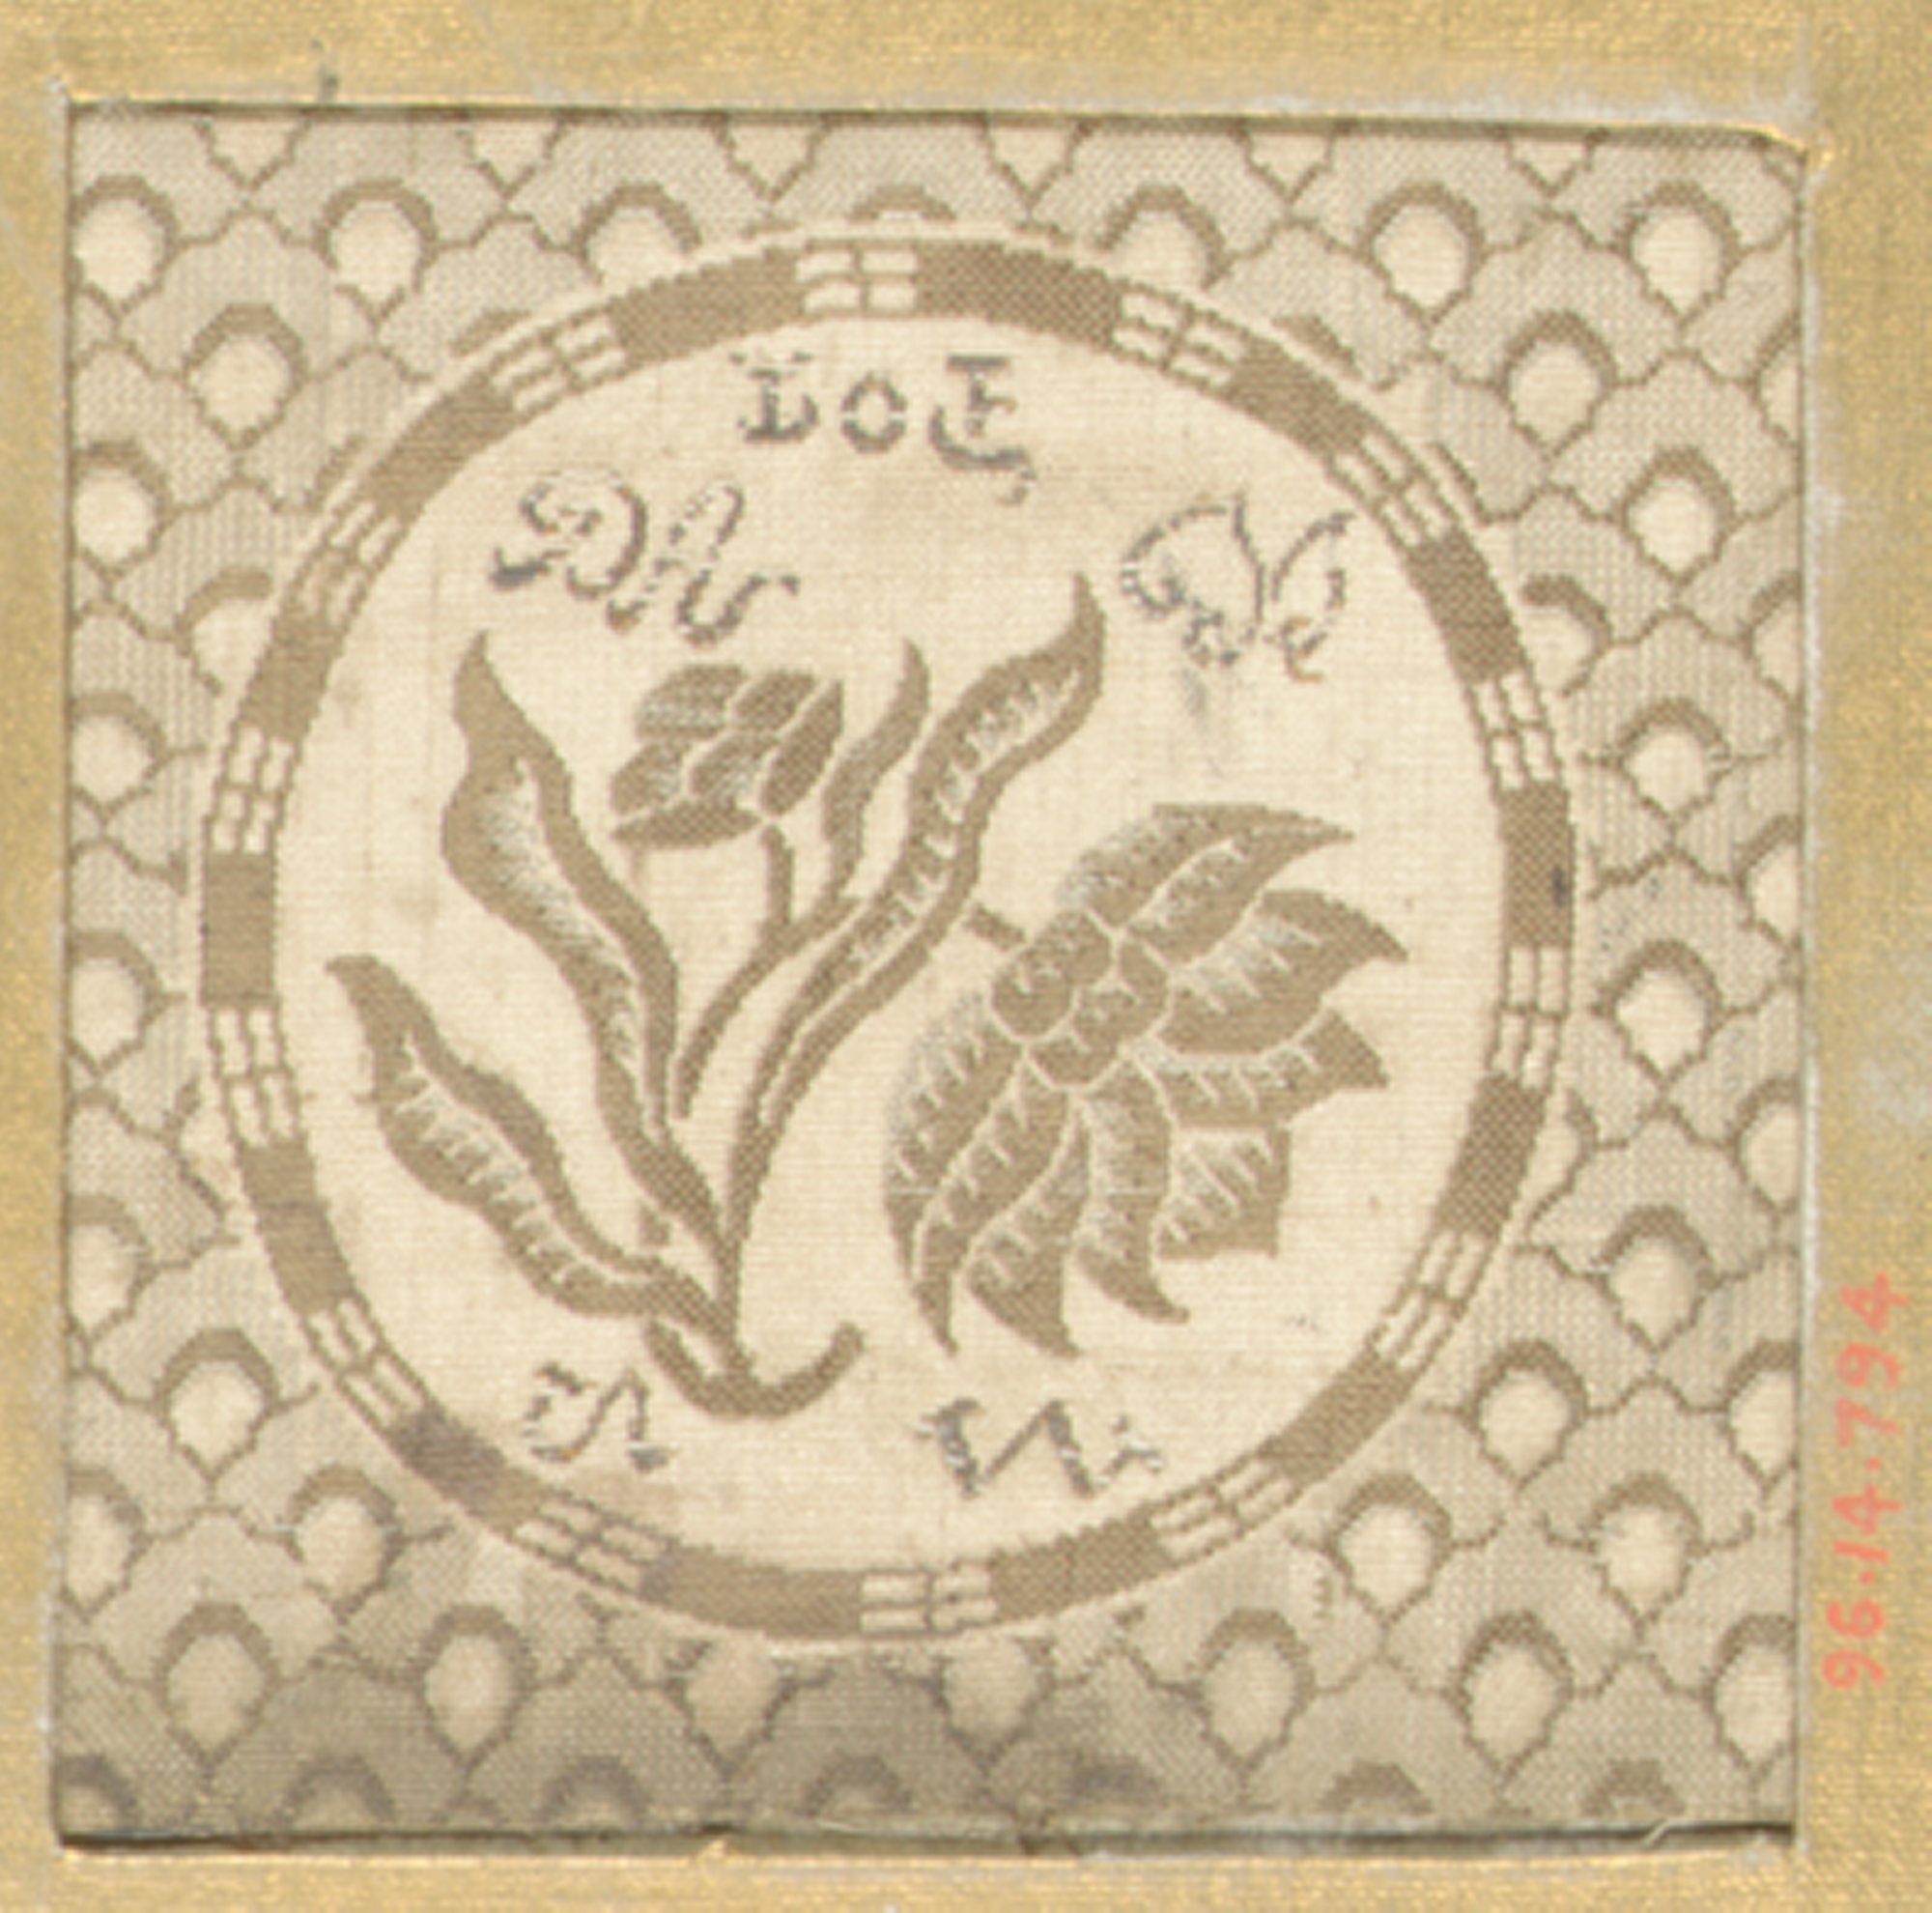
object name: piece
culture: japanese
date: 1701-1900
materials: silk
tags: leaves